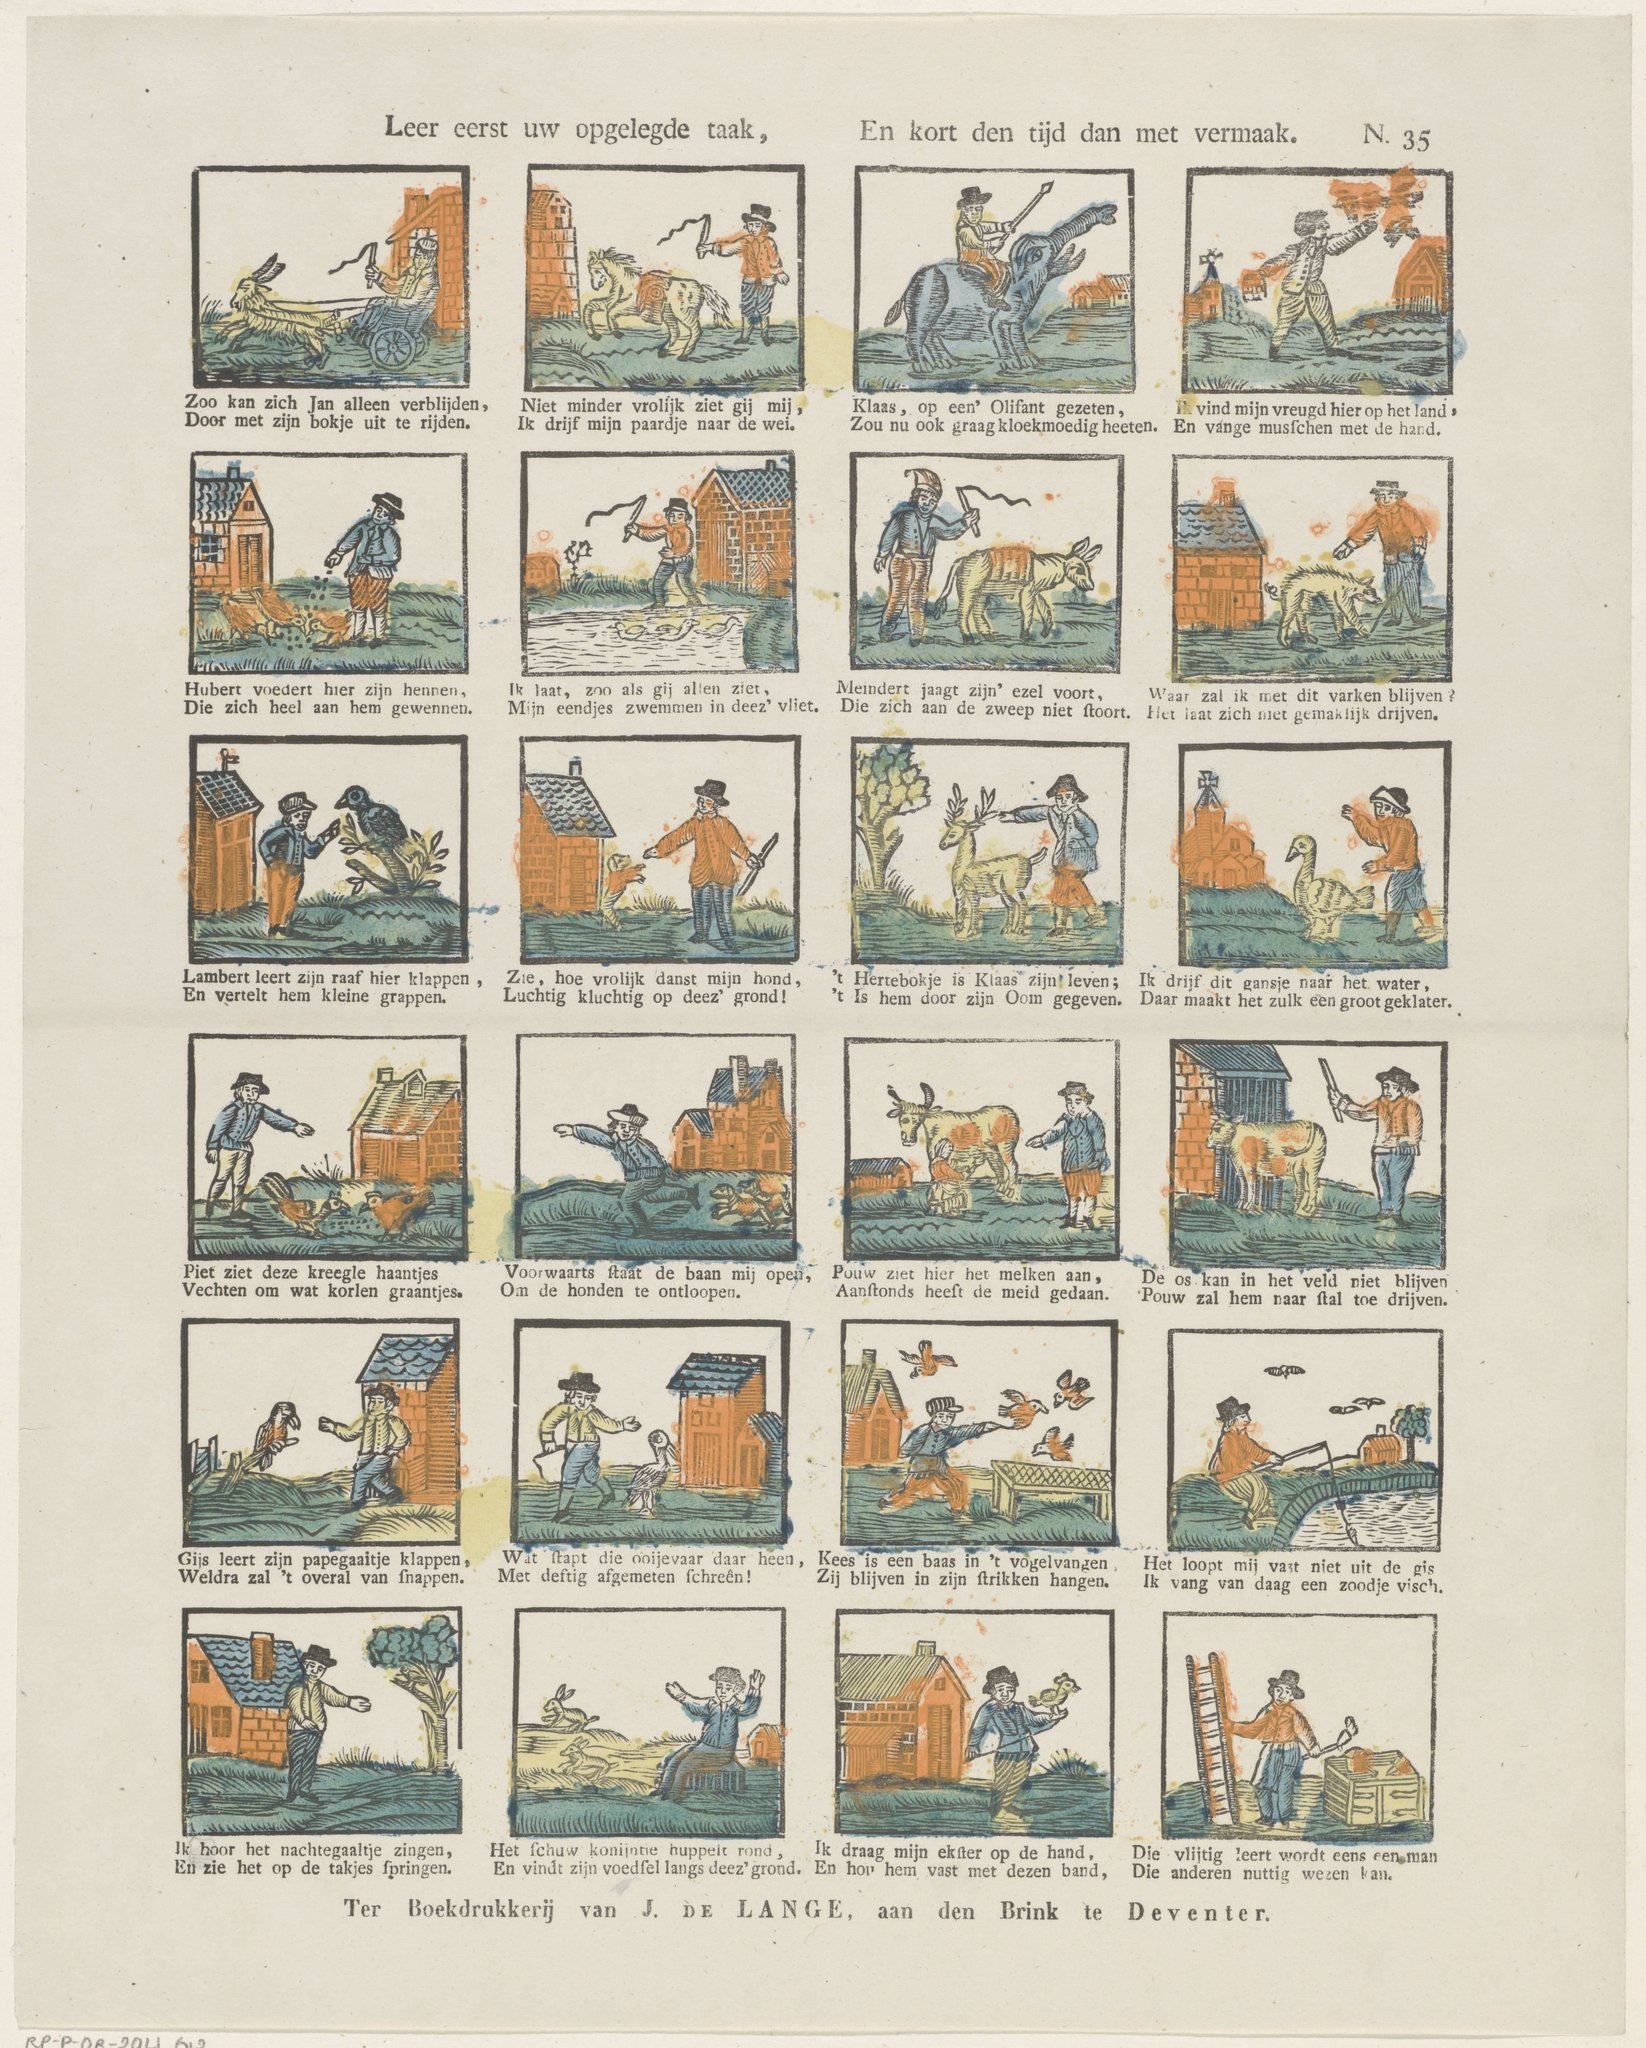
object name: print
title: Leer eerst uw opgelegde taak, / En kort den tijd dan met vermaak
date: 1822-1849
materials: paper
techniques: colour, letterpress printing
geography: netherlands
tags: child playing with animals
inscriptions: collector's mark: Lugt 2760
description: Blad met 24 voorstellingen van kinderen die spelen met dieren. Onder elke afbeelding een tweeregelig vers. Genummerd rechtsboven: N. 35.